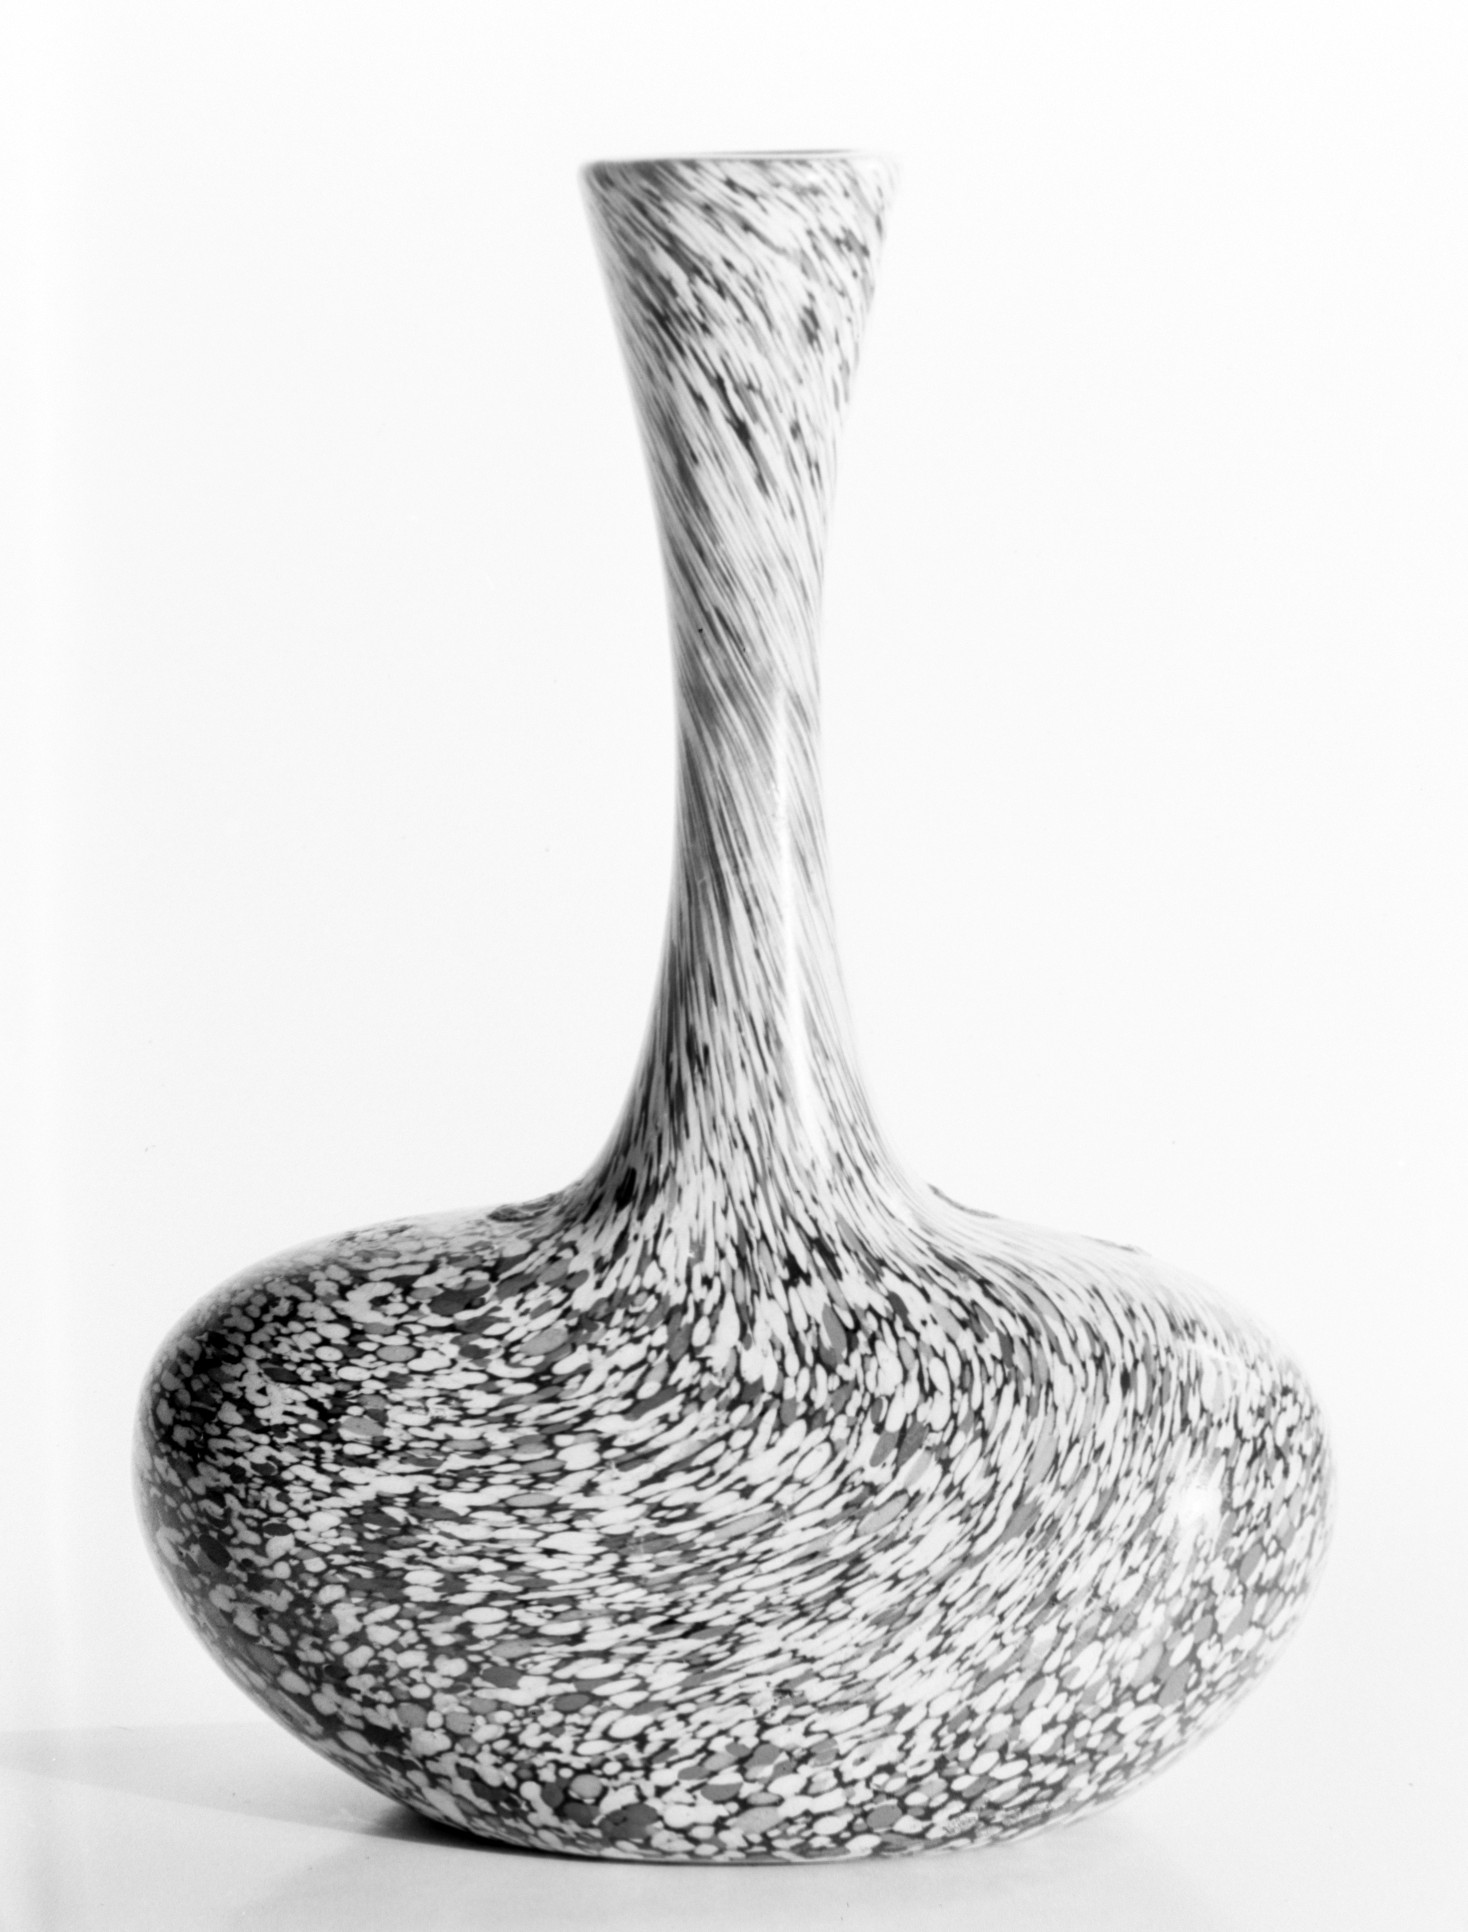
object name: bottle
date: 1601-1700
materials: glass